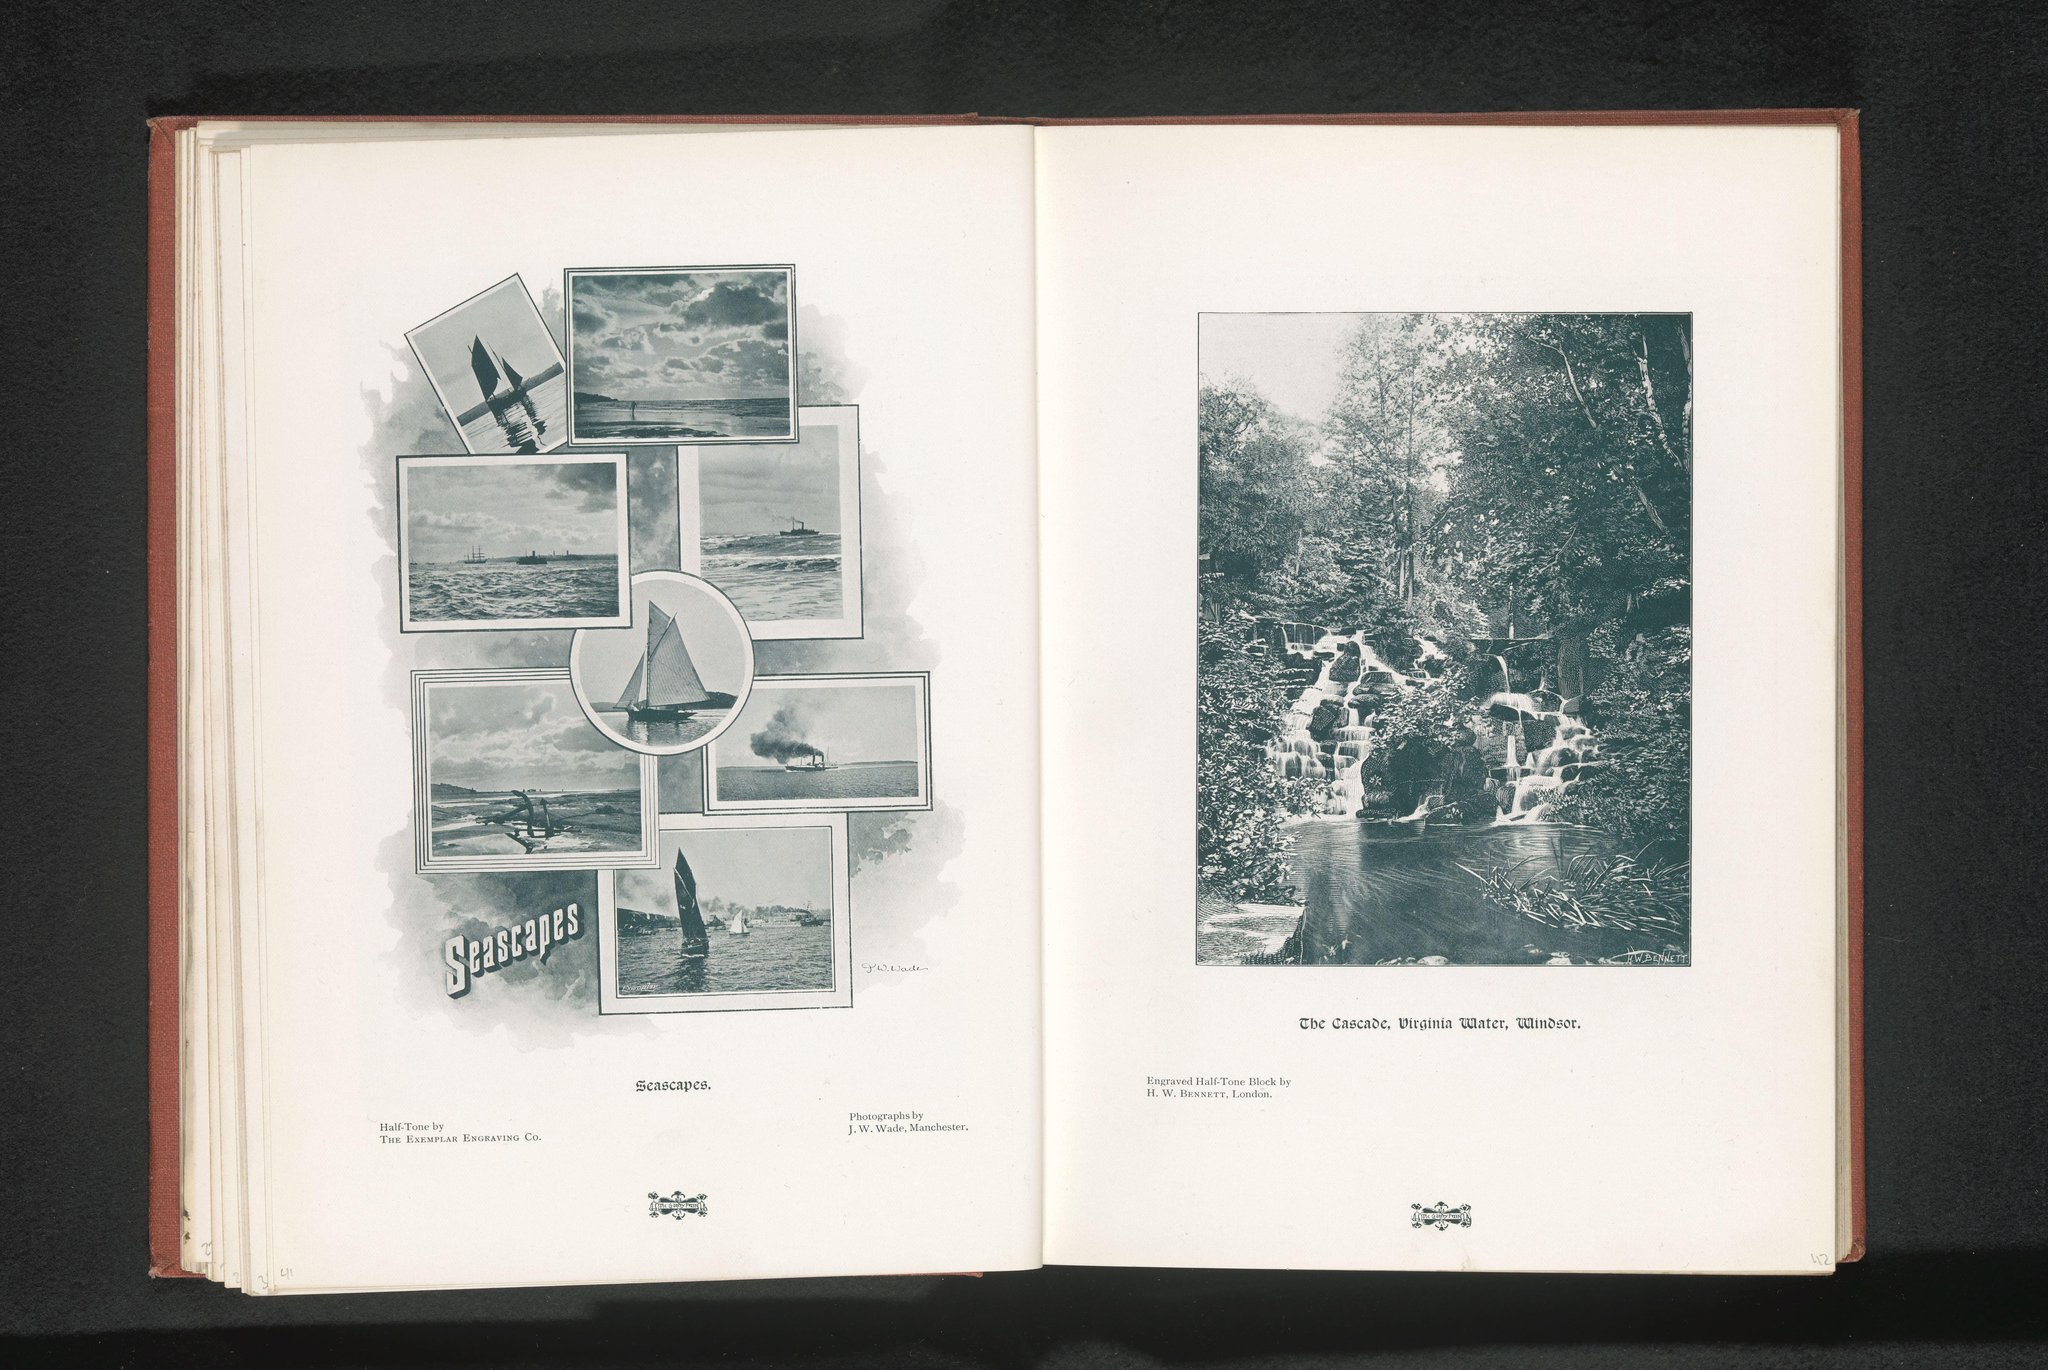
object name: page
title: Seascapes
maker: j.w. wade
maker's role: fotograaf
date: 1895-1900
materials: paper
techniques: autotype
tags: sailing-ship, sailing-boat, sea (seascape), steamship, motorship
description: Prent op zesde ongenummerde pagina na pagina 32.